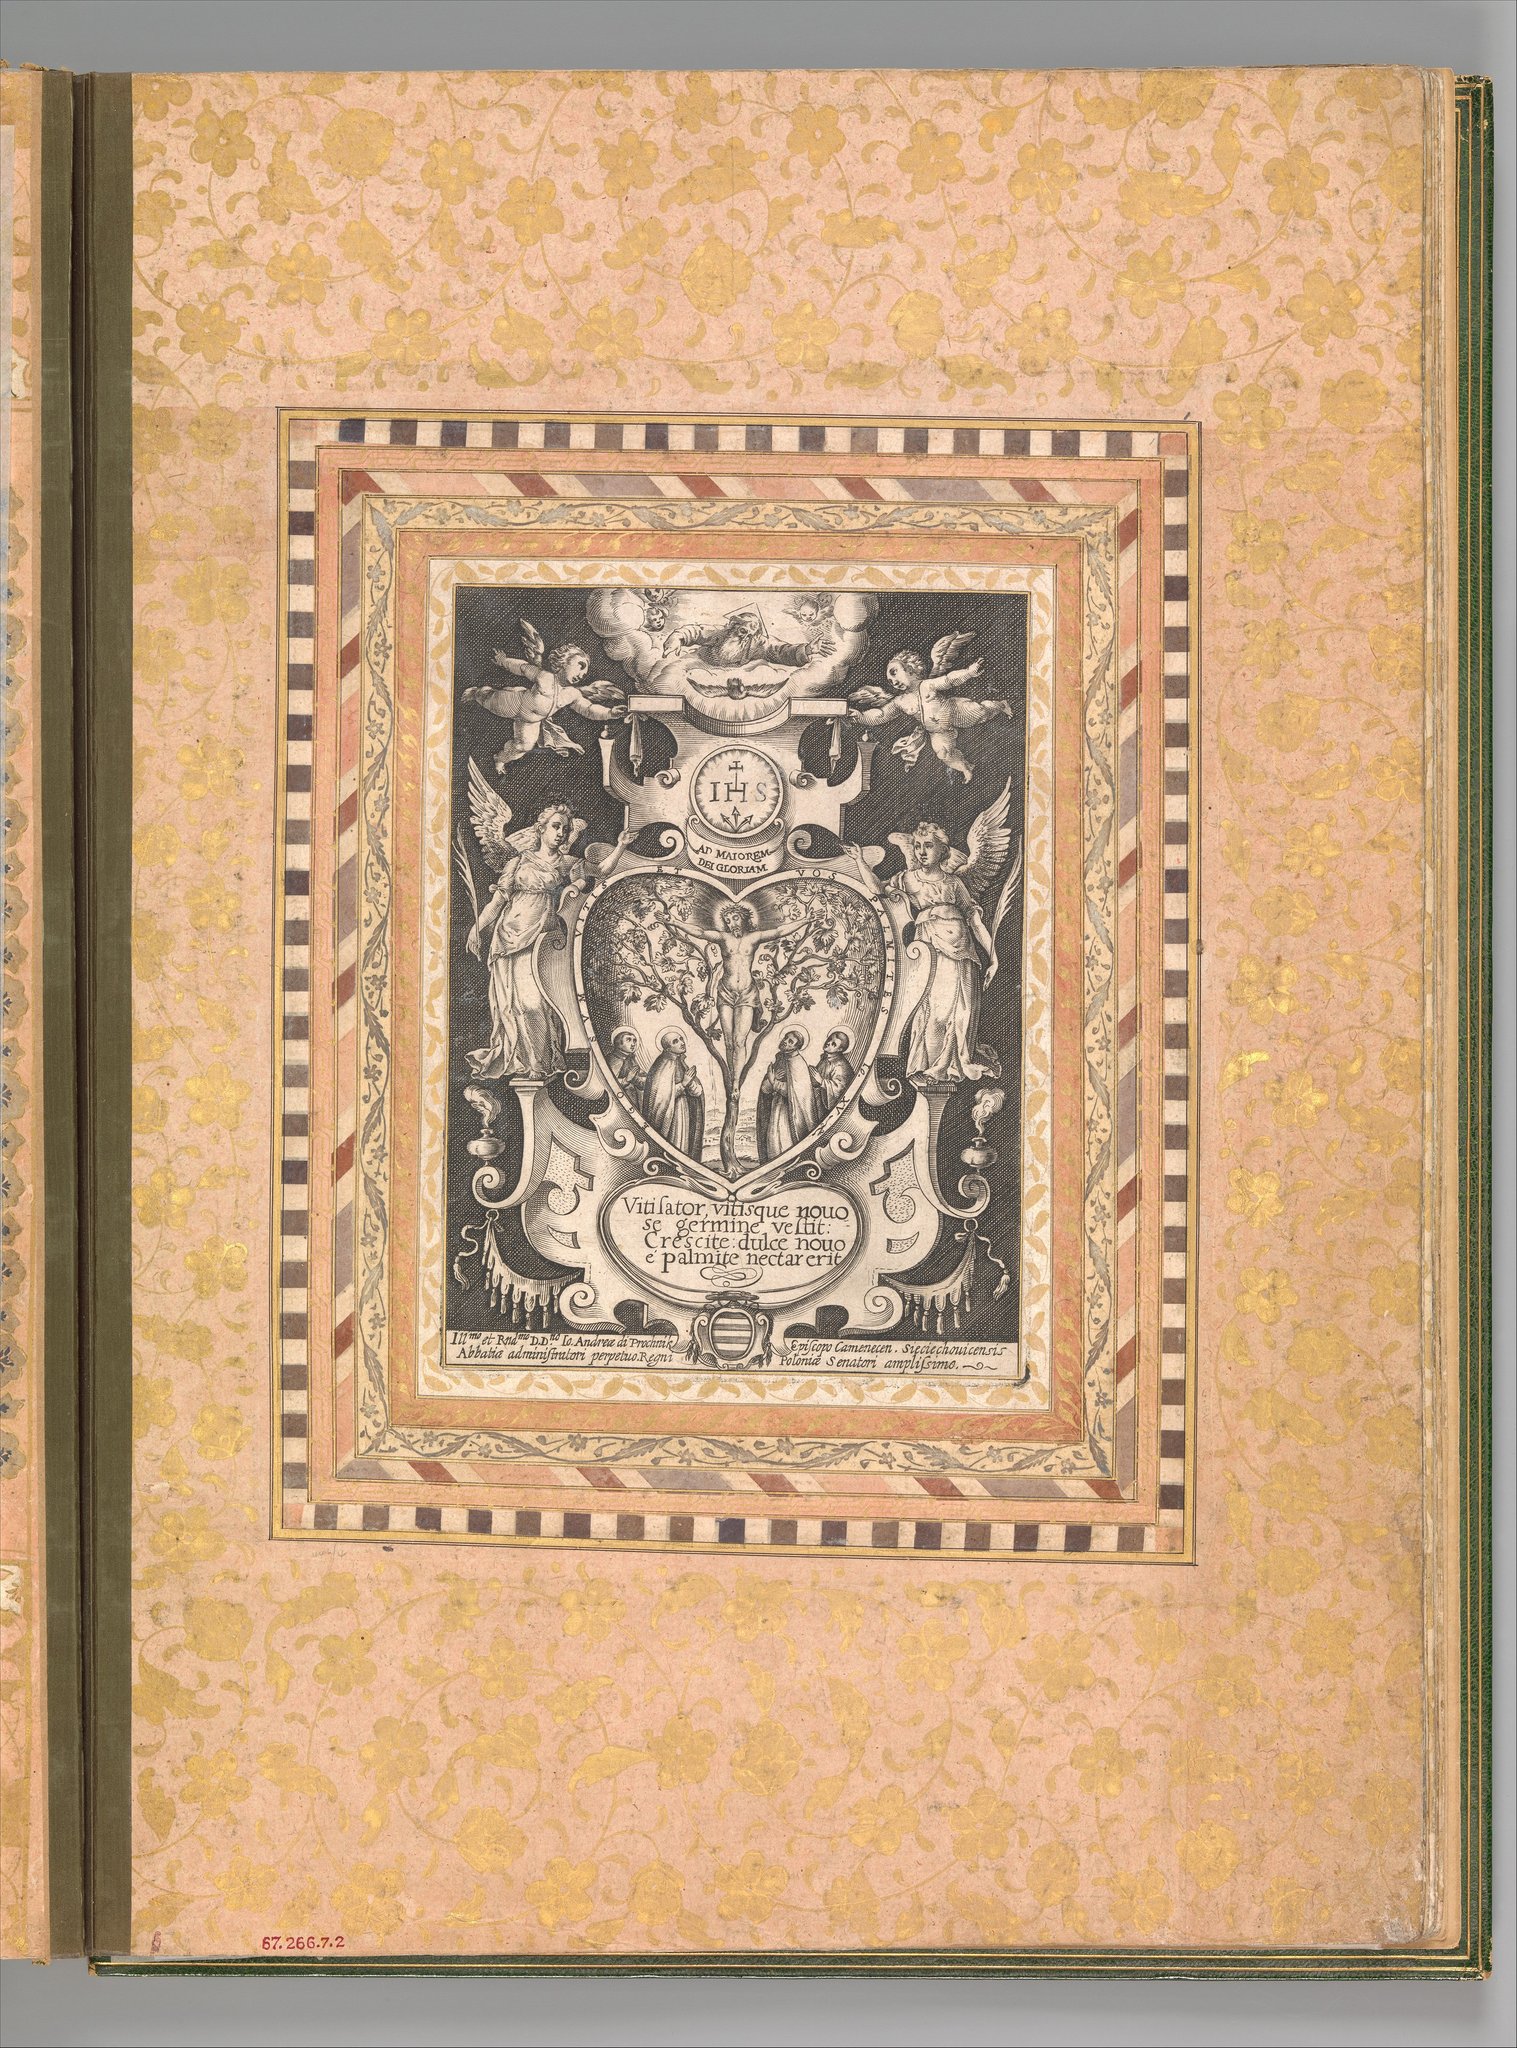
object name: illustrated album leaf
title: "Devotional Scene," Folio from the Bellini Album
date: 1600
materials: gold, ink, paper, watercolor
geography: netherlands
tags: men,christ,crucifixion,coat of arms